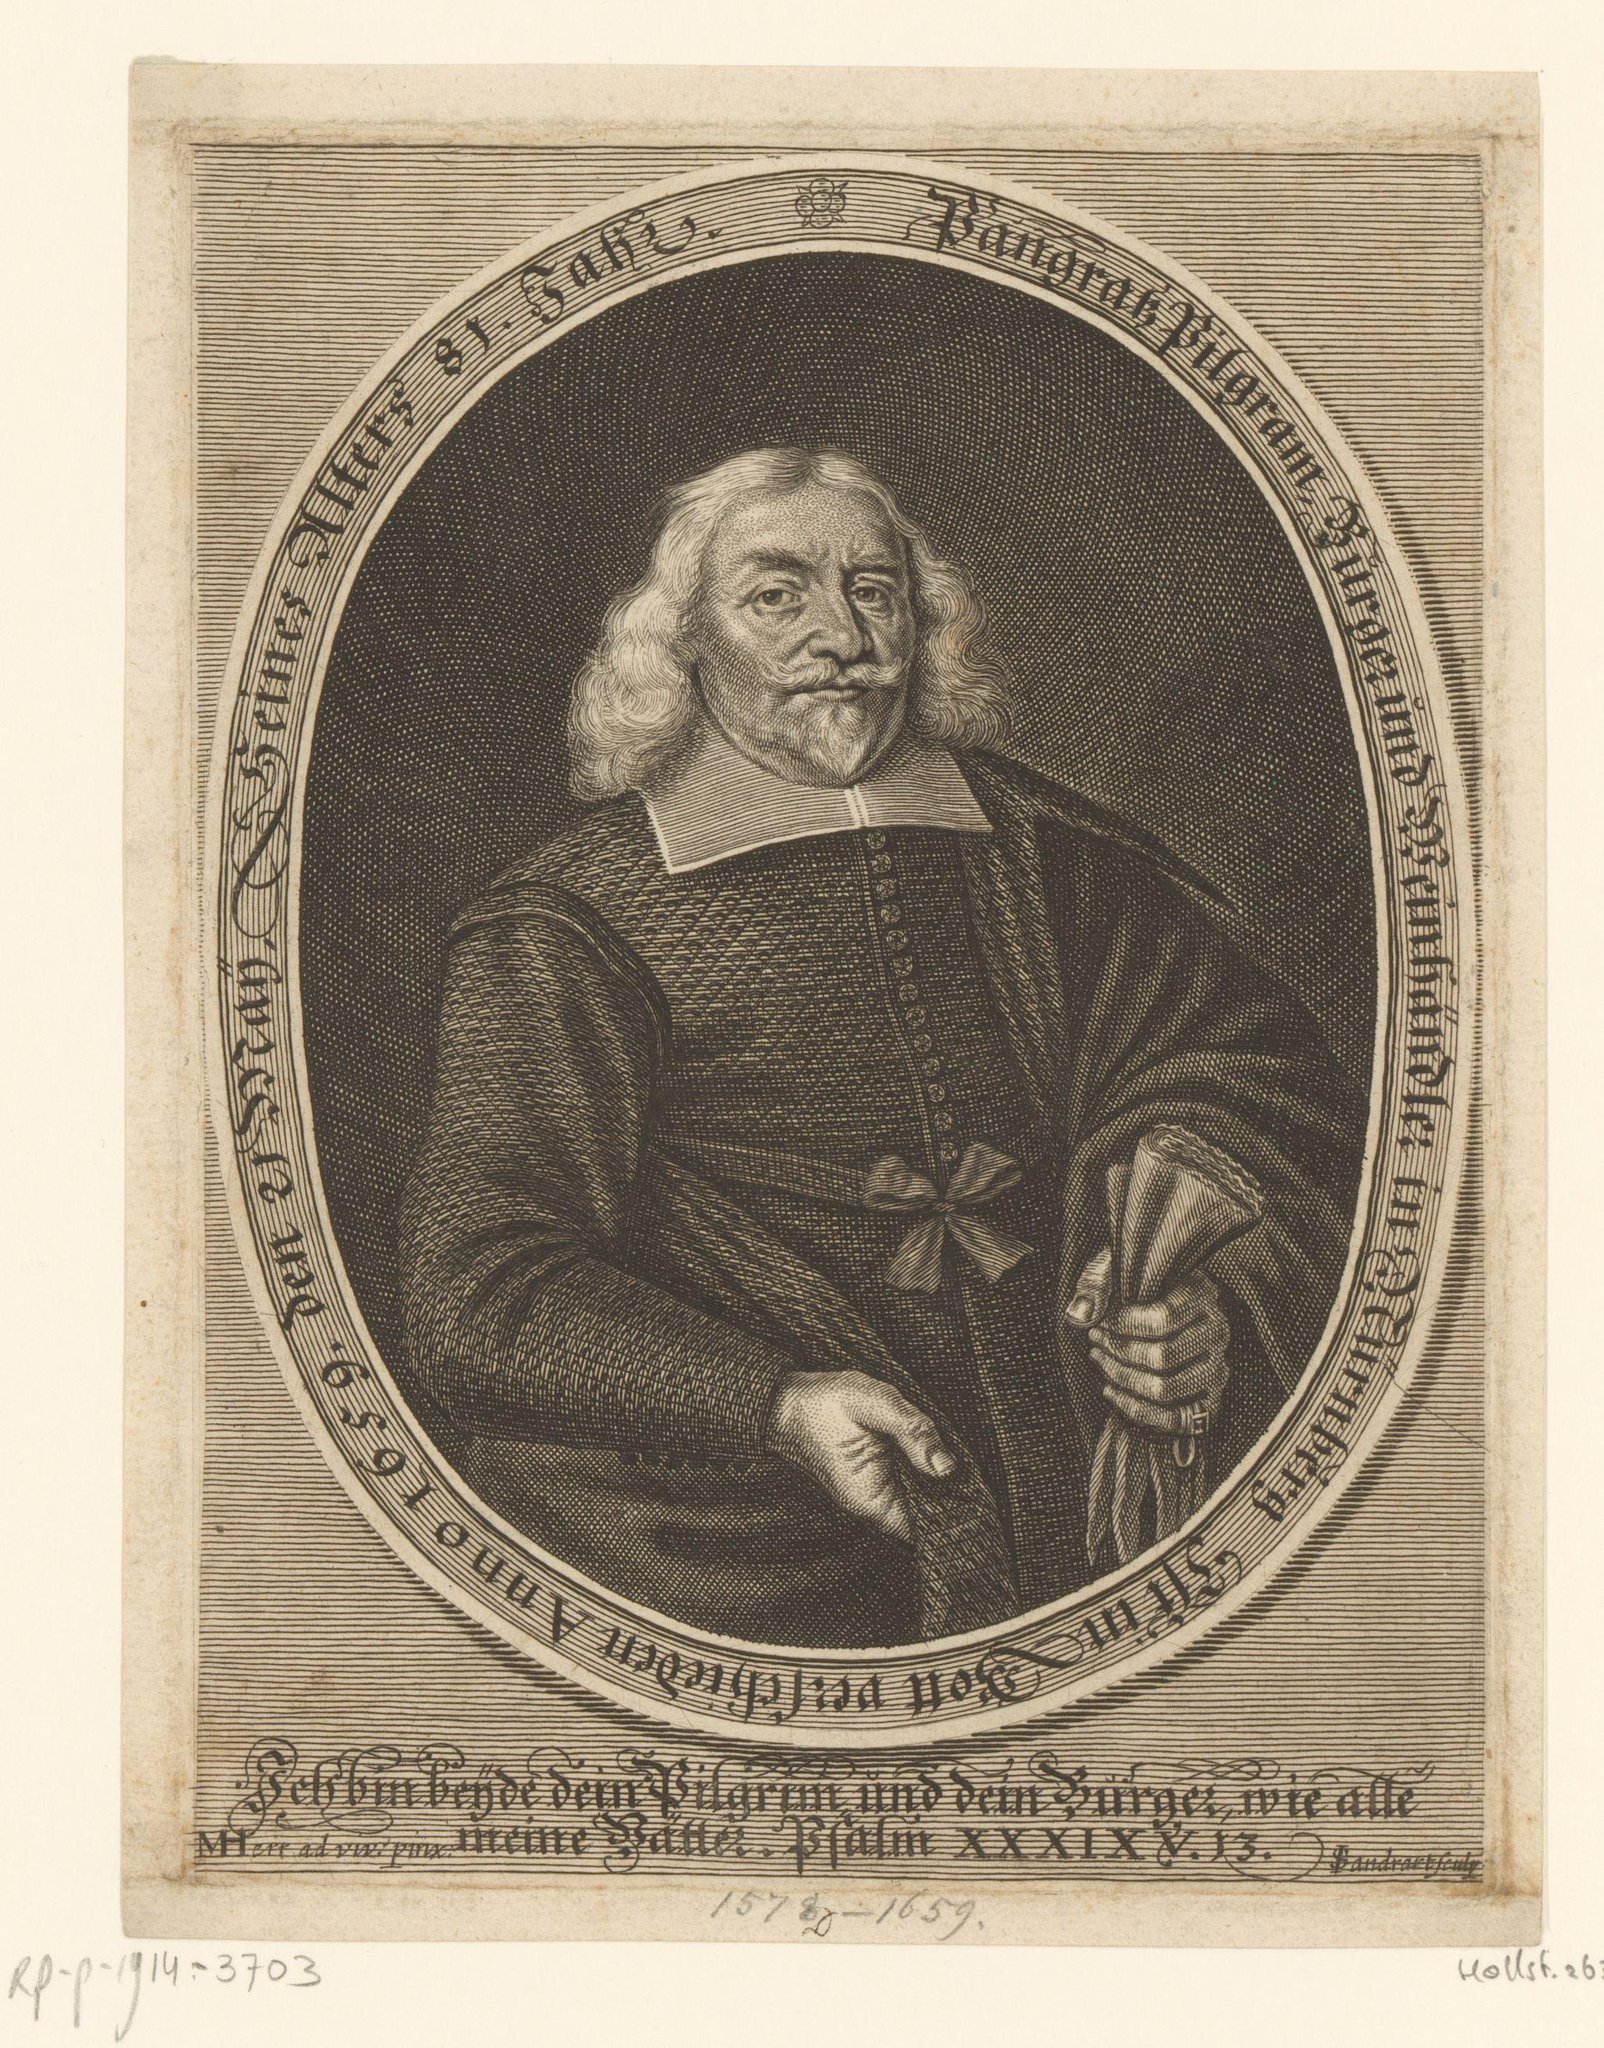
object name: print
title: Portret van Pancraz Pilgram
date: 1659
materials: paper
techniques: engraving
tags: historical persons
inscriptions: collector's mark: Lugt 2228